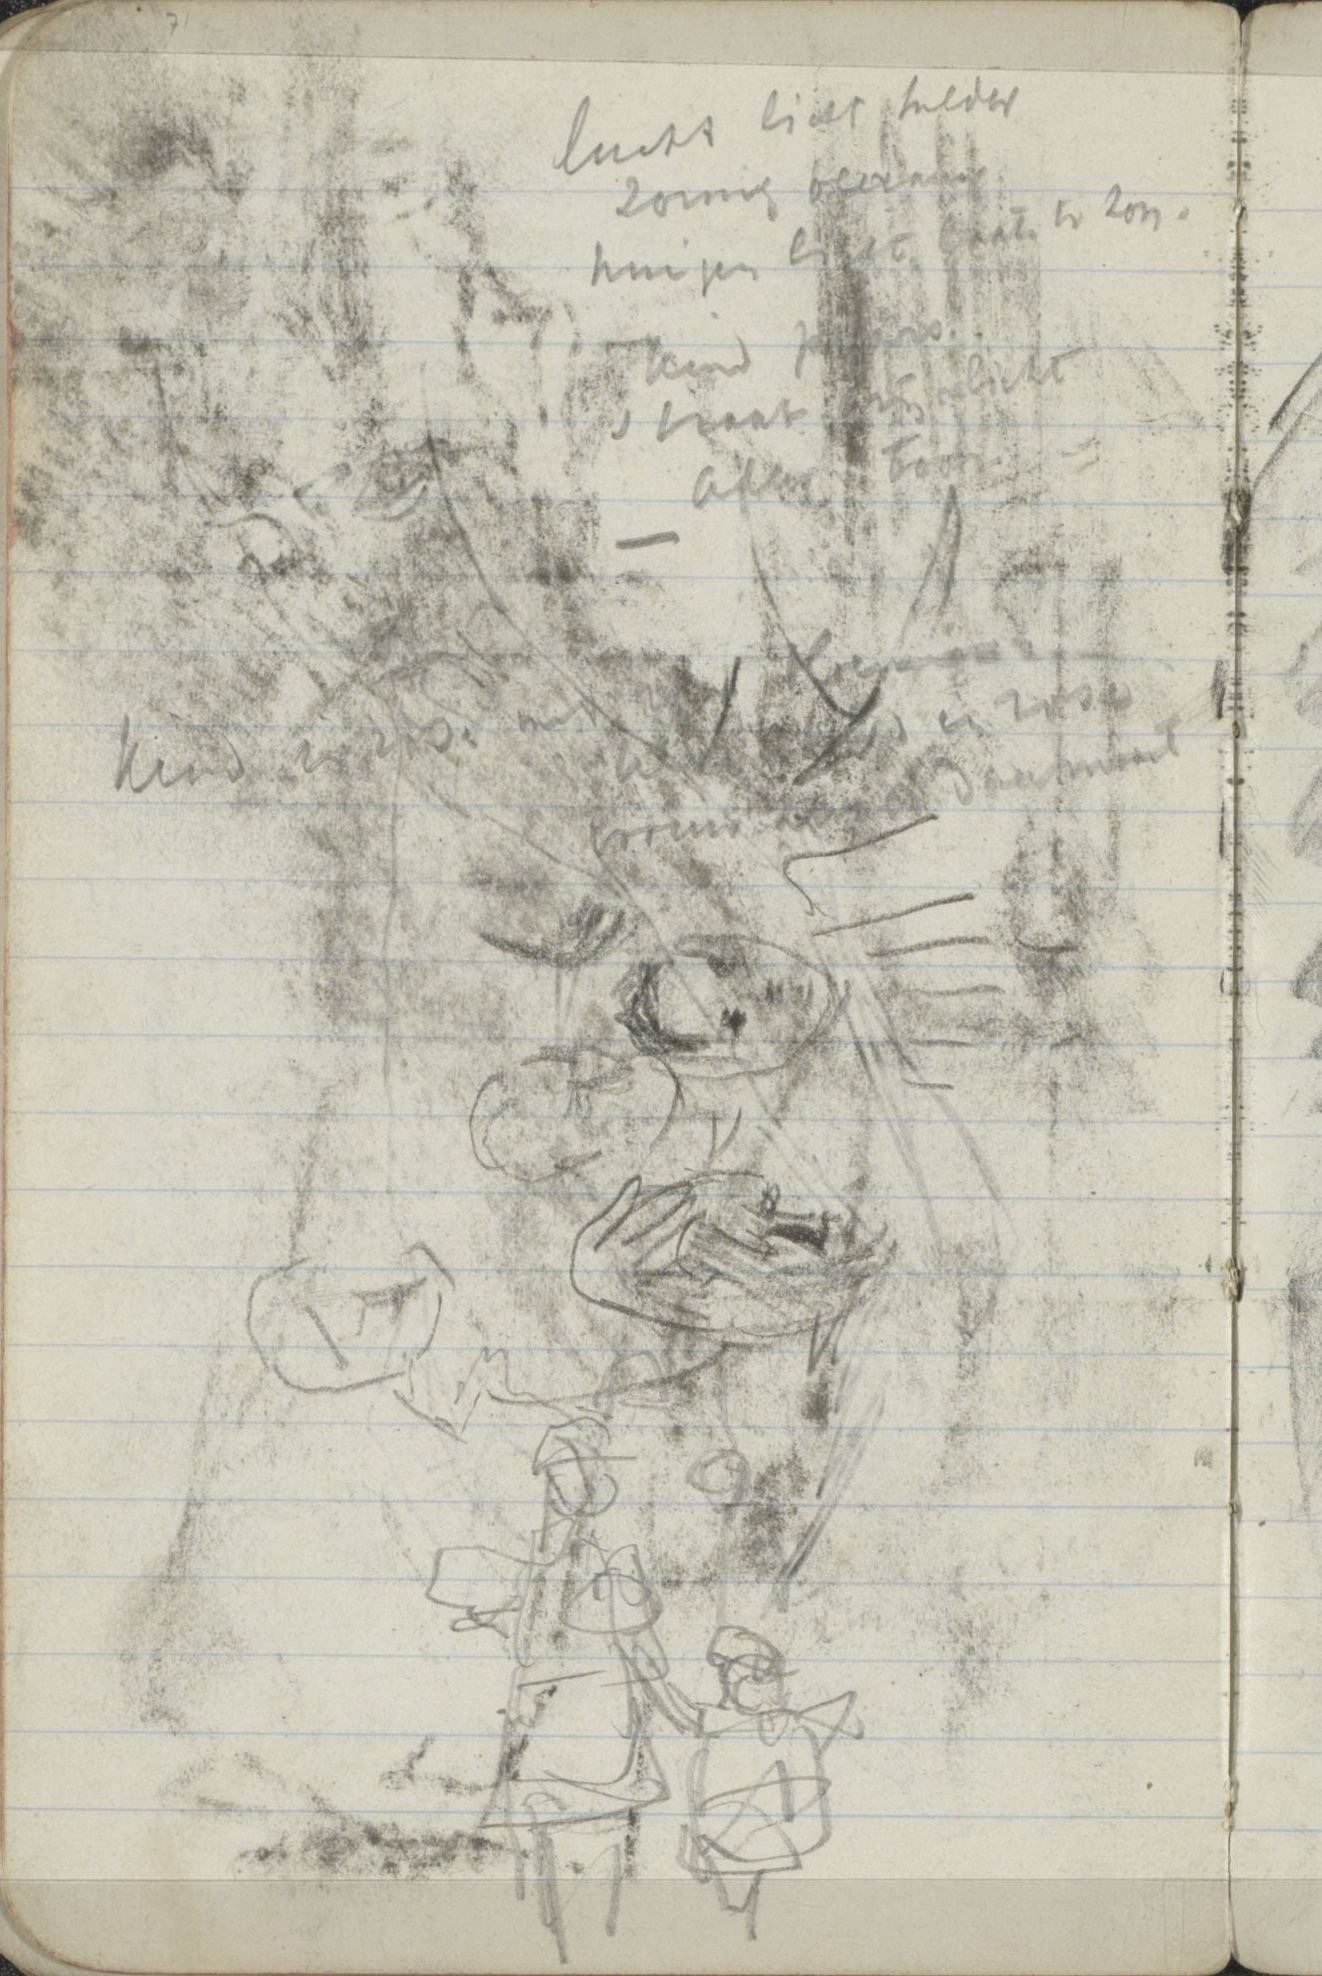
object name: sketchbook leaf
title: Figuurstudies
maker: george hendrik breitner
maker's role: draughtsman, painter, print maker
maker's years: 1857-1923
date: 1893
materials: chalk, pencil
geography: amsterdam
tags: adult woman, adult man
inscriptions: : ‘lucht licht helder/ zonnig [...]’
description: Pagina 71 uit een schetsboek met 38 bladen.